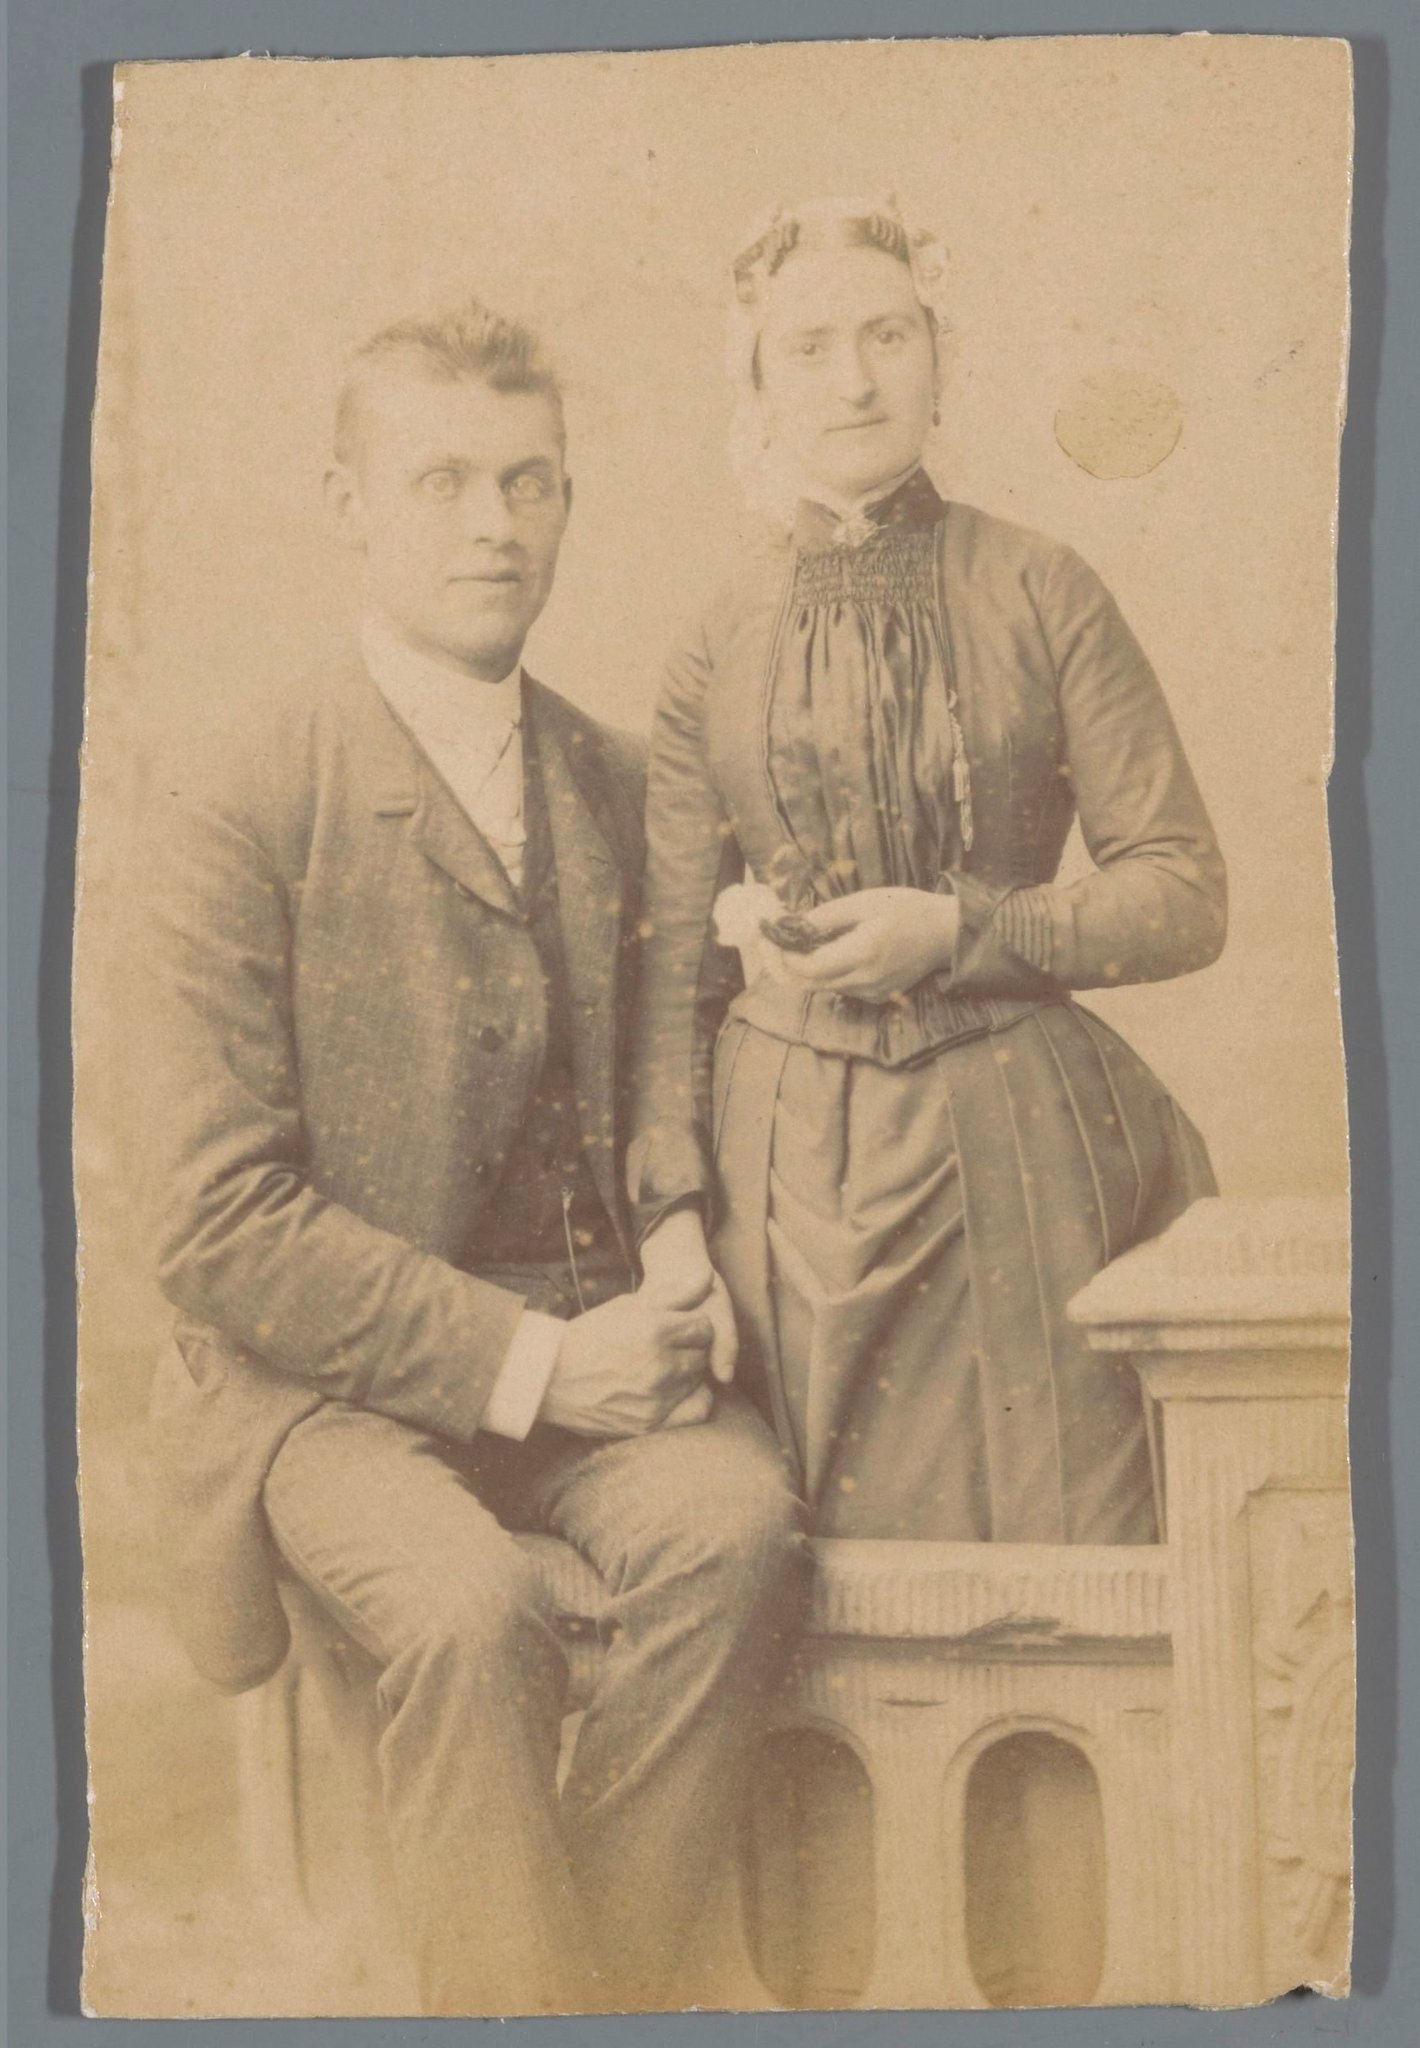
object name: carte de visite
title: Portret van een onbekende man en vrouw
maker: albert greiner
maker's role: fotograaf, fotostudio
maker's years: 1833-1890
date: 1883-1887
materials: cardboard, paper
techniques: albumen print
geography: amsterdam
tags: anonymous historical person portrayed, couple of lovers, amsterdam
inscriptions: inscription: ‘Albert Greiner/ Kon-Ned-Hof-Photograaf/ Amsterdam/ Nieuwendijk 89./ Specialiteit in Vergrootingen.’